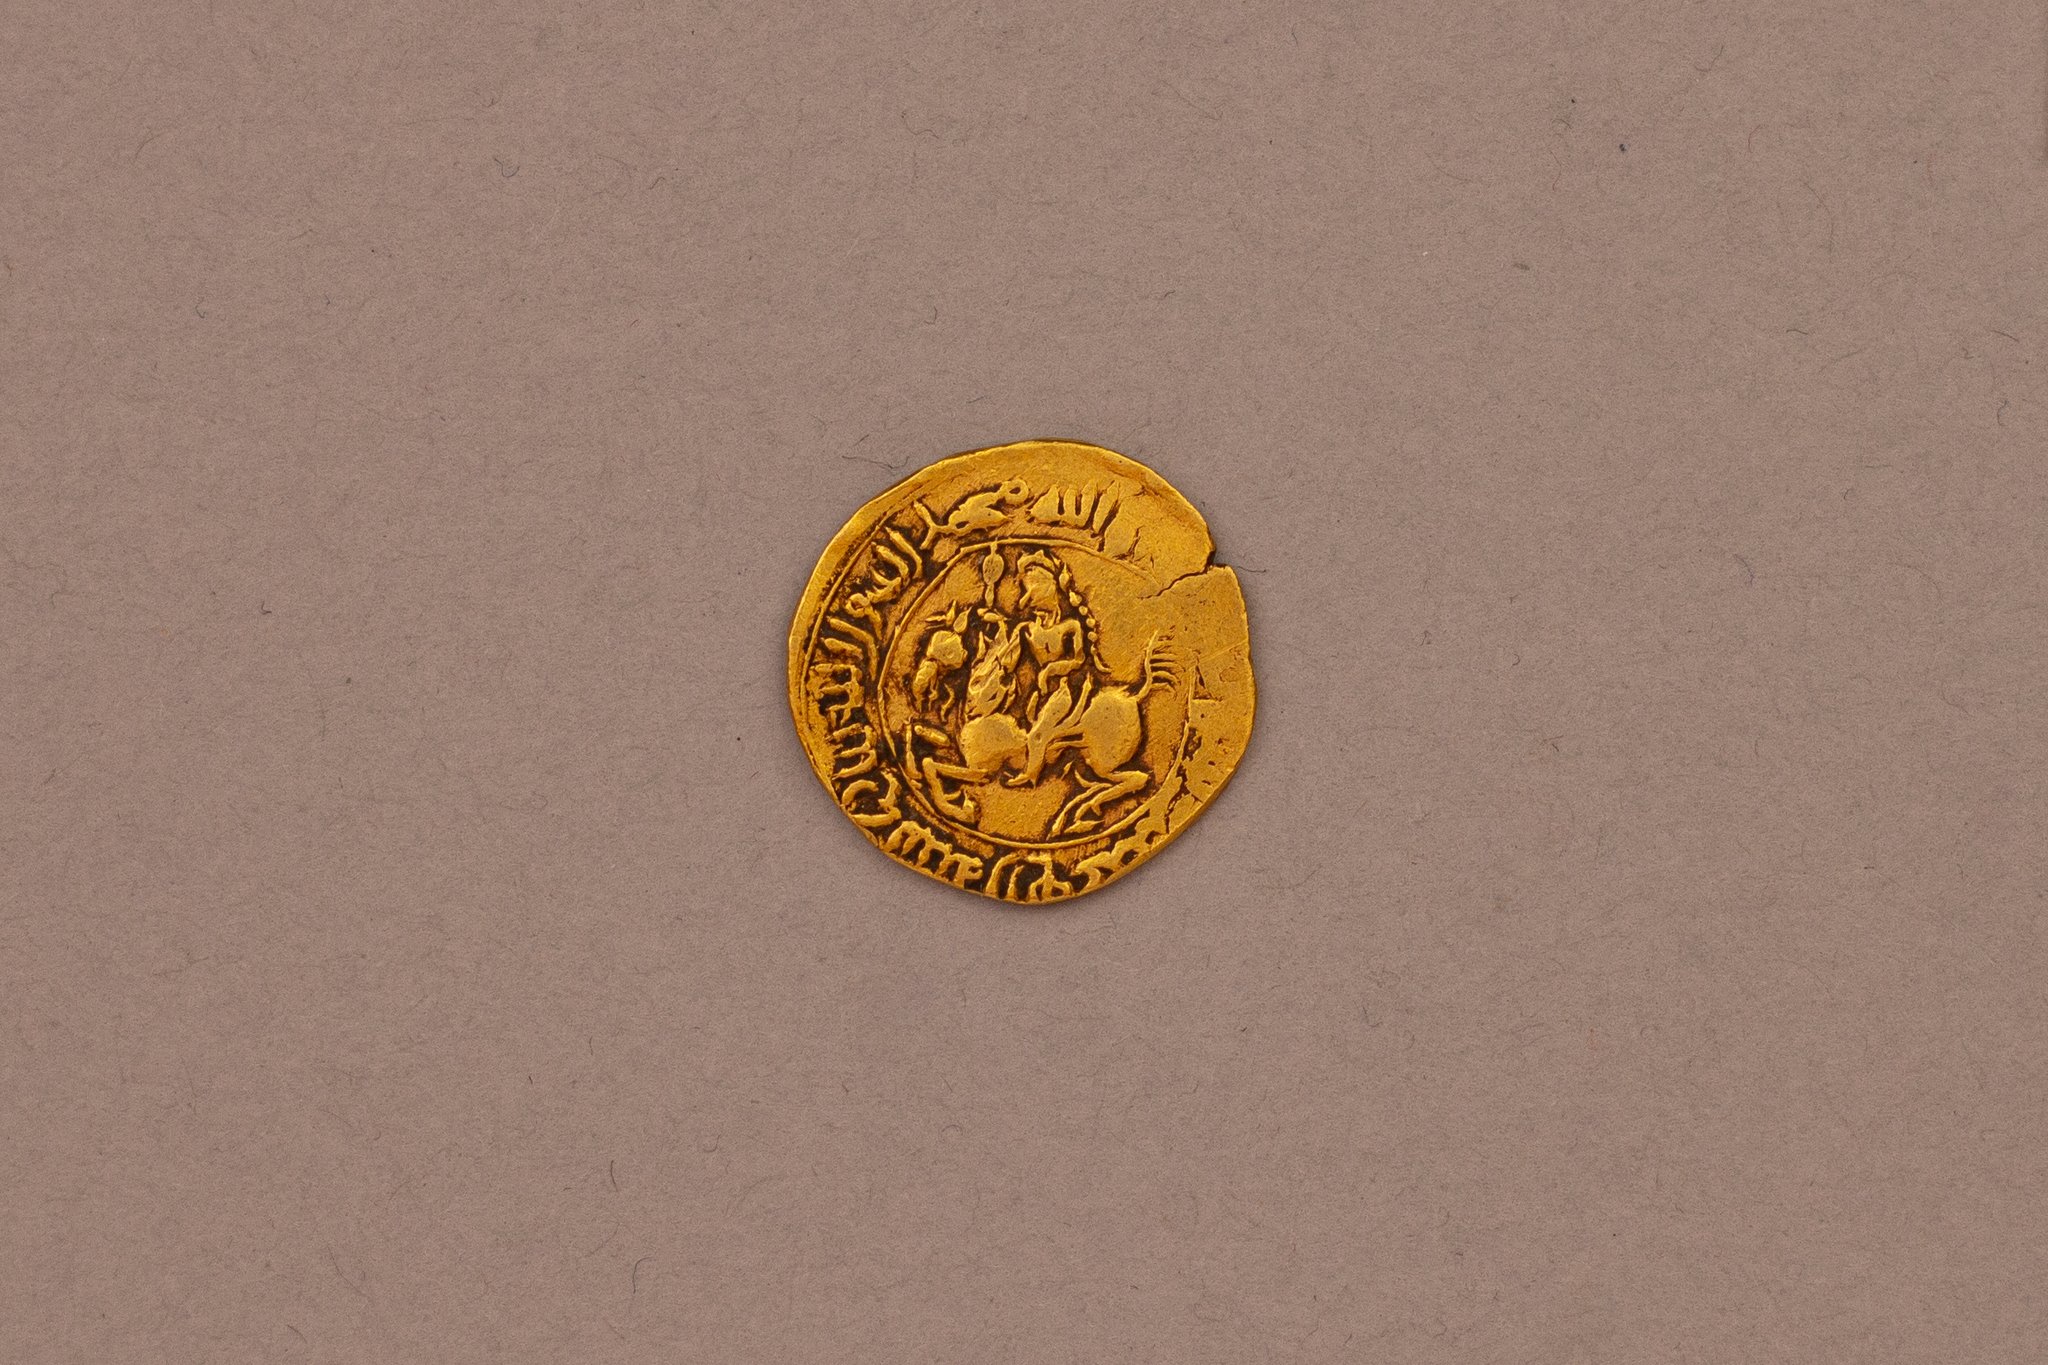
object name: coin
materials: gold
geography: india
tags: horses